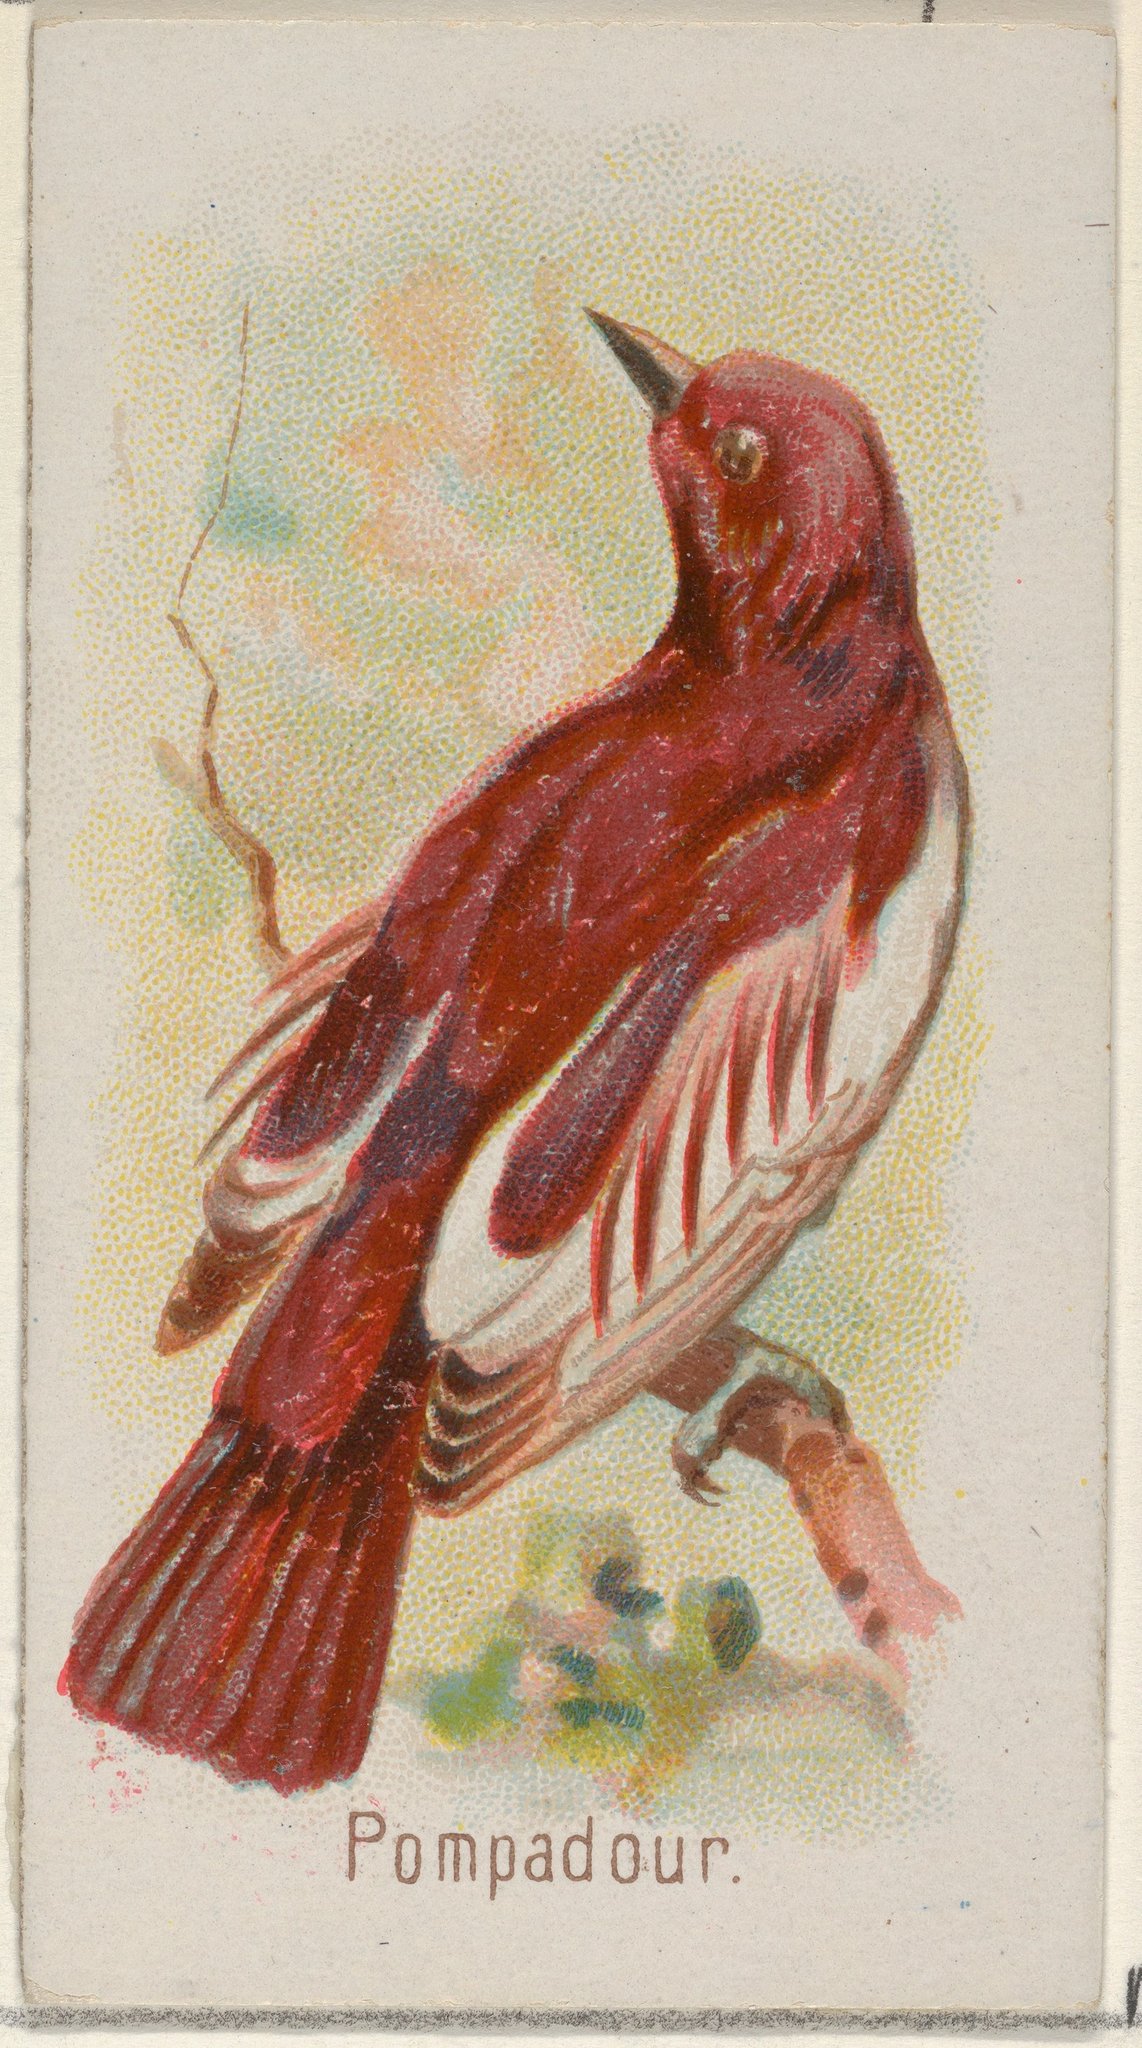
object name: print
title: Pompadour, from the Song Birds of the World series (N23) for Allen & Ginter Cigarettes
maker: allen & ginter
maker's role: publisher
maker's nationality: american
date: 1890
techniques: color lithograph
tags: birds